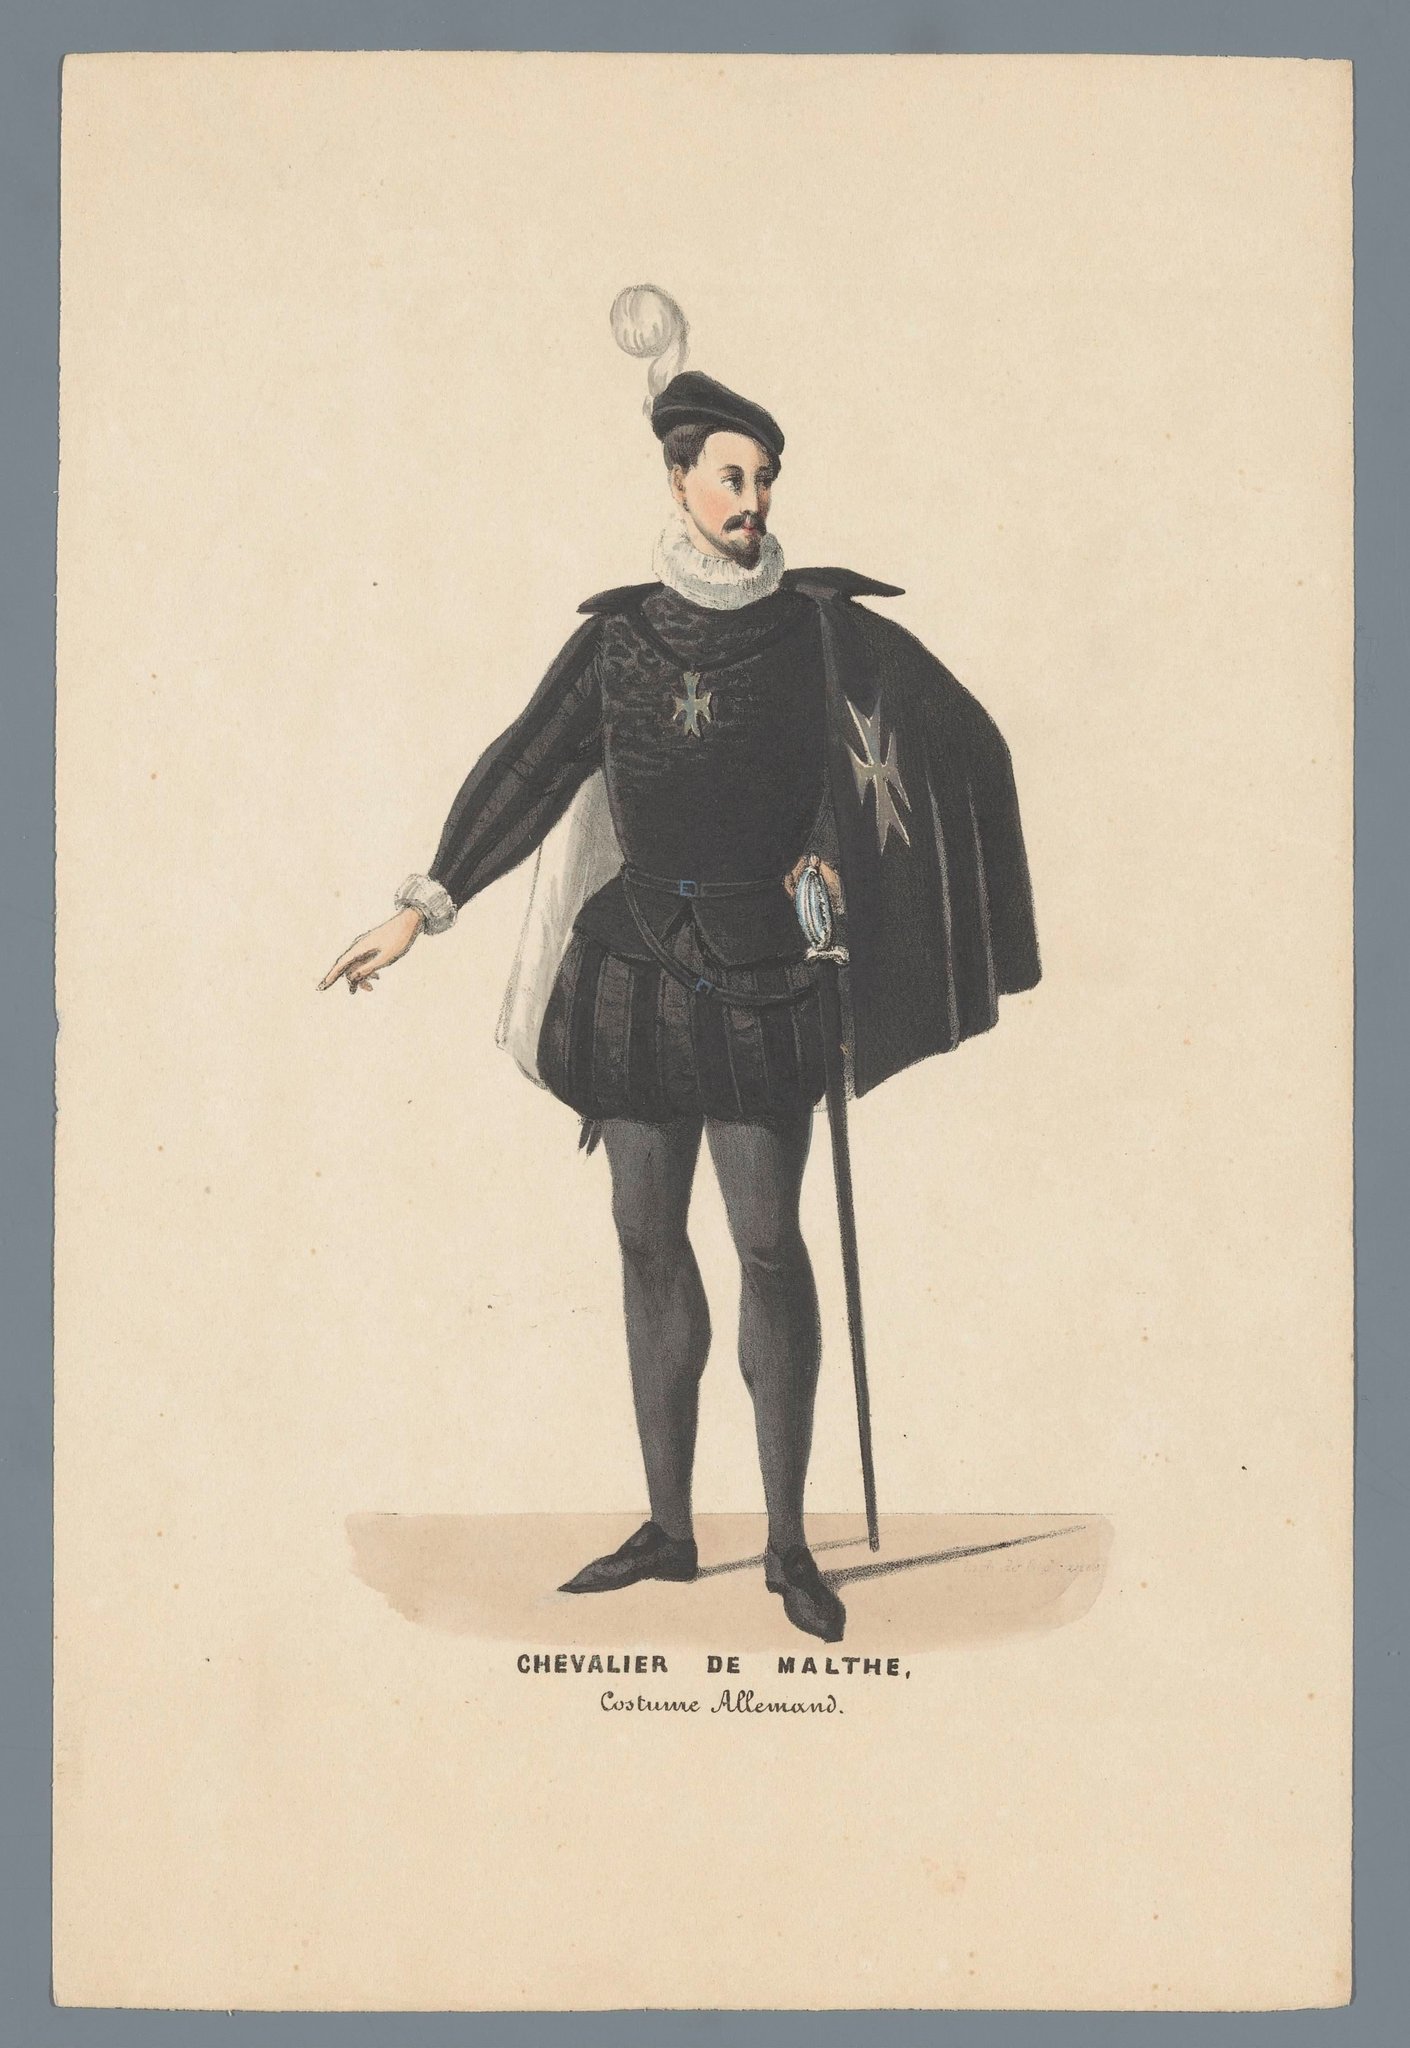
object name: costume print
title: Chevalier De Malthe, Costume Allemand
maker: elias spanier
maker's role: print maker, printer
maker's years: 1821-1863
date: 1840-1850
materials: paper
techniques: hand coloring, lithograph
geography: the hague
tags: historical costume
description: Man in kostuum van een Duitse ridder van de Maltezer Orde, 16e eeuw. Voorstelling toegevoegd aan het plaatwerk over het gekostumeerd bal gehouden op het paleis van de prins van Oranje (de latere koning Willem III) in Den Haag op 26 februari 1845.